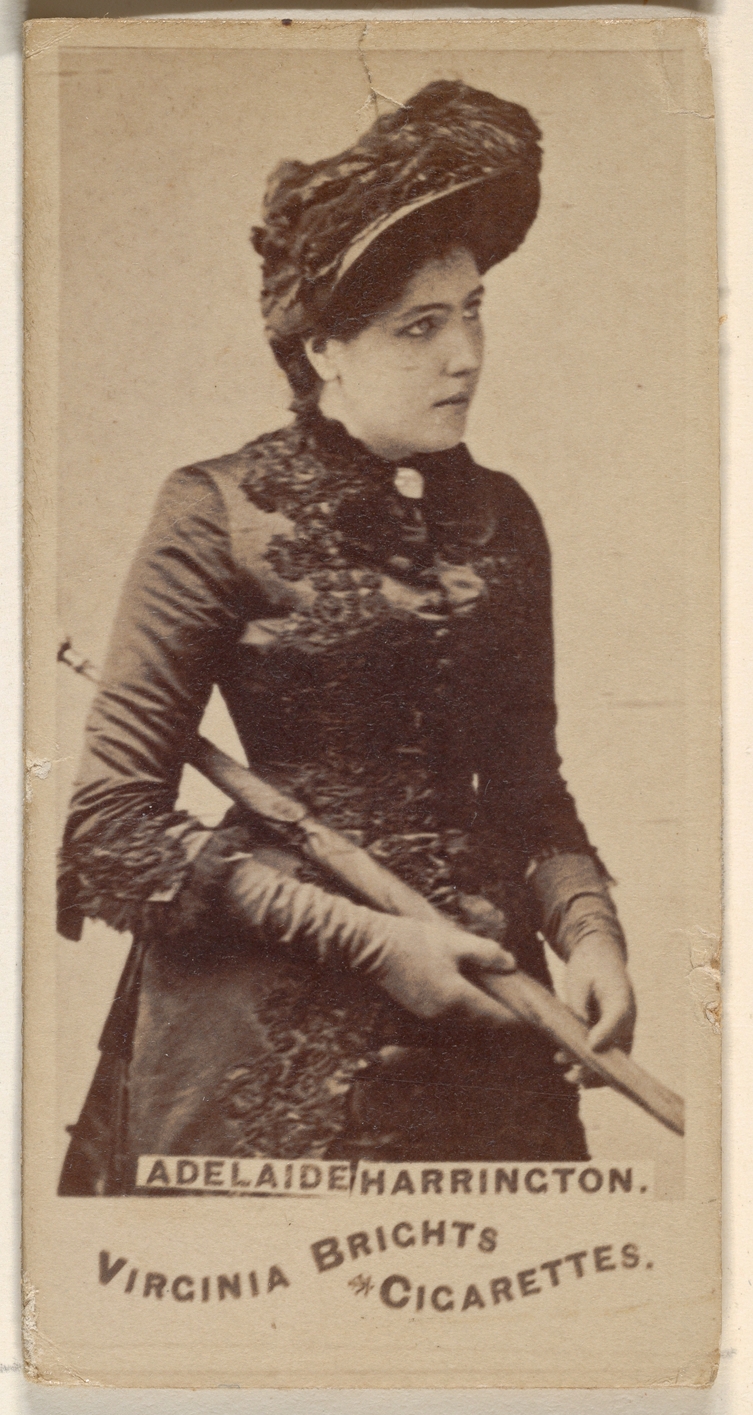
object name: photograph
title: Adelaide Harrington, from the Actors and Actresses series (N45, Type 1) for Virginia Brights Cigarettes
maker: allen & ginter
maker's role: publisher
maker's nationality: american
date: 1888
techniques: albumen silver print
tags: portraits,women,actresses